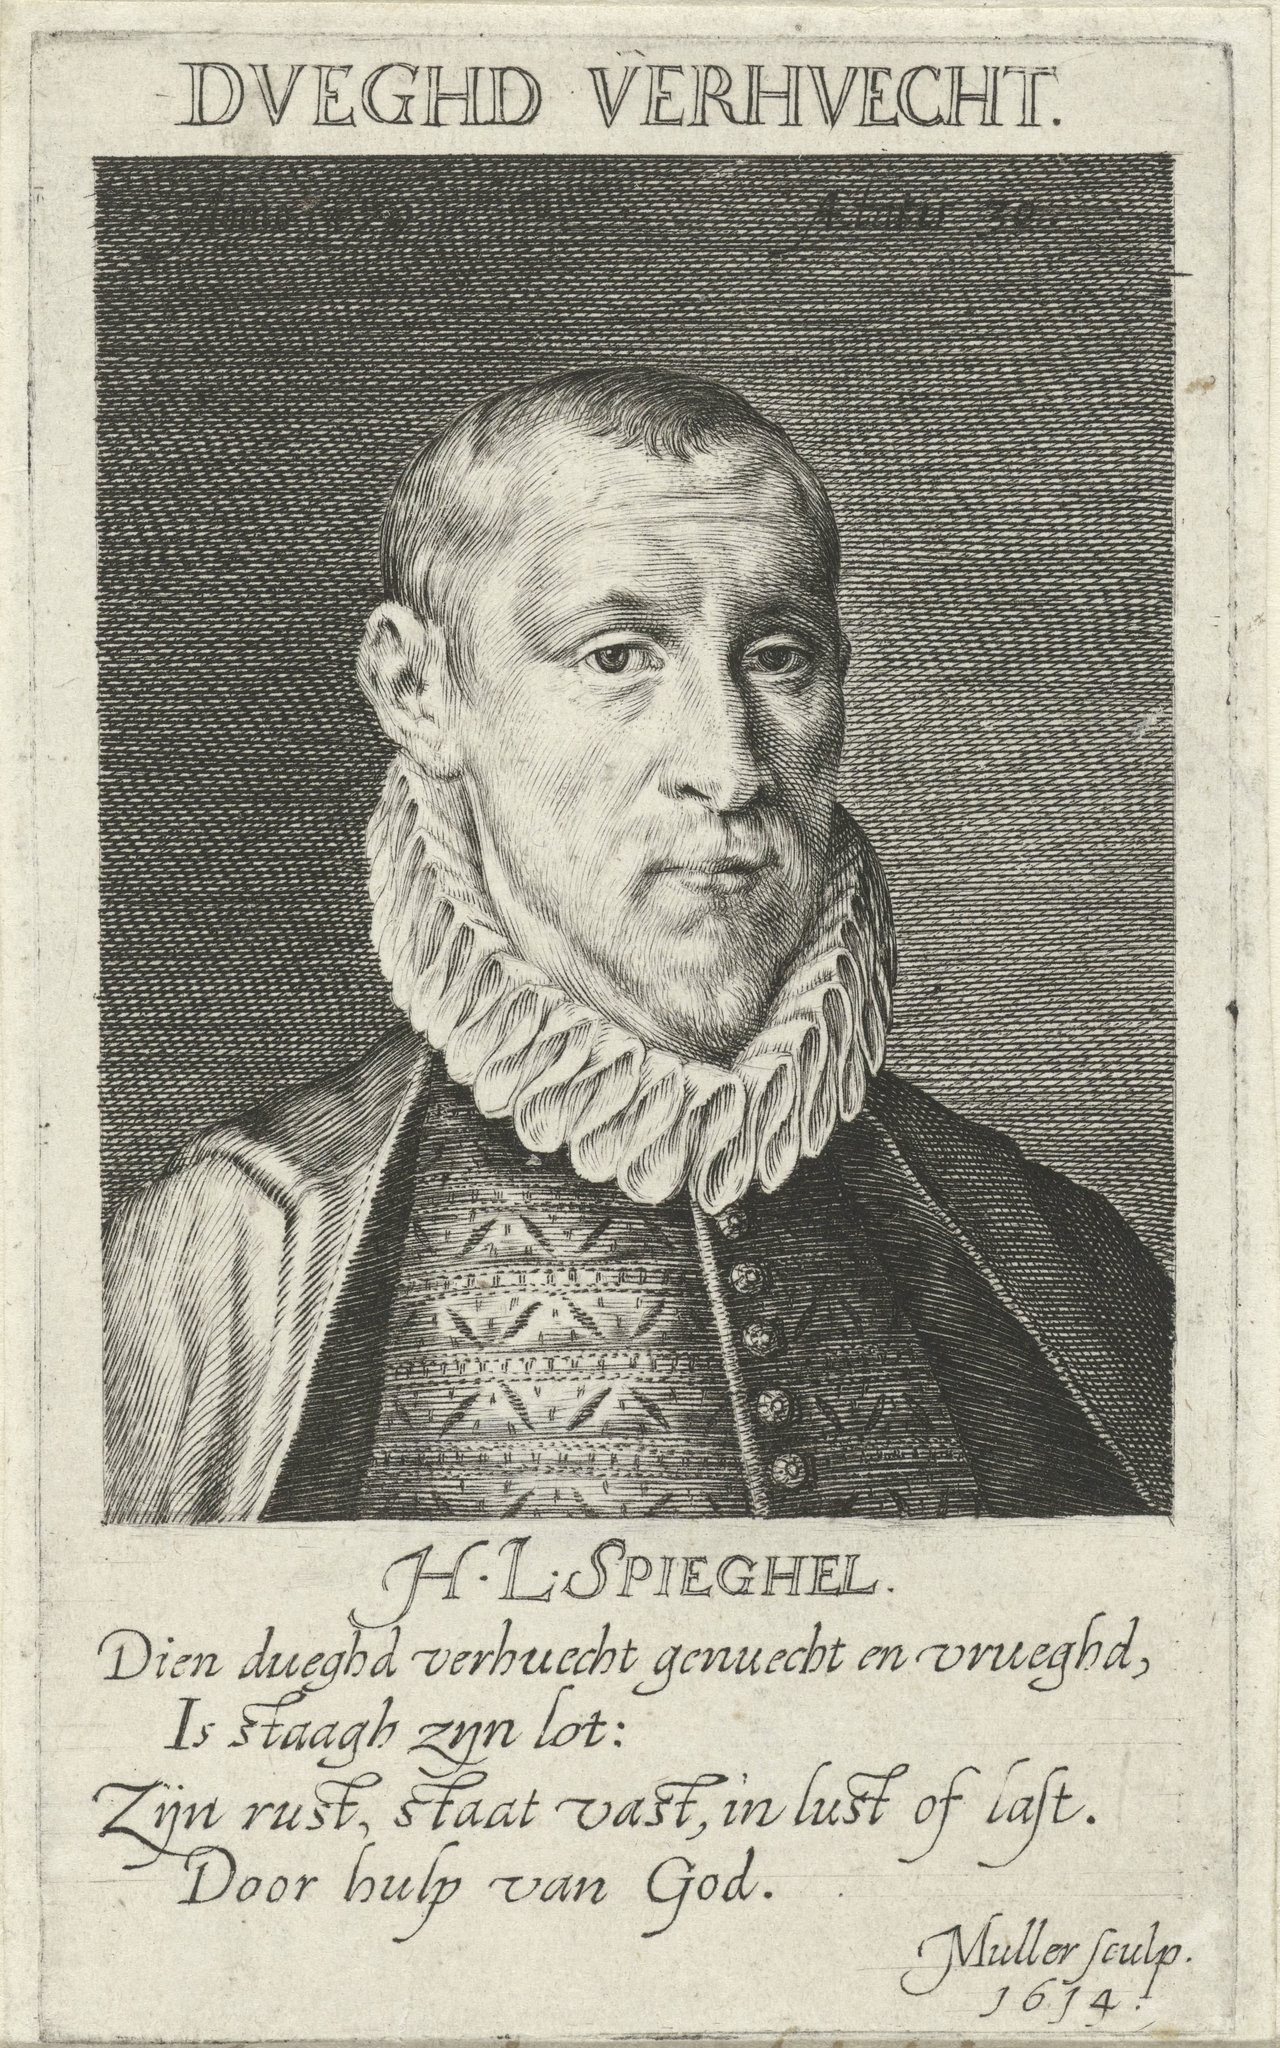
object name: print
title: Portret van Hendrick Laurensz. Spieghel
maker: jan harmensz. muller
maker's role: draughtsman, print maker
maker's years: 1571-1628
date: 1614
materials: paper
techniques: engraving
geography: amsterdam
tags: amsterdam, hendrick laurensz. spieghel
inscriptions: collector's mark: Lugt 2228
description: Portret van Hendrick Laurensz. Spieghel, schrijver en dichter, op 30-jarige leeftijd. Boven het portret zijn persoonlijke spreuk. Onderaan in de marge een vierregelig vers over de geportretteerde in het Nederlands.